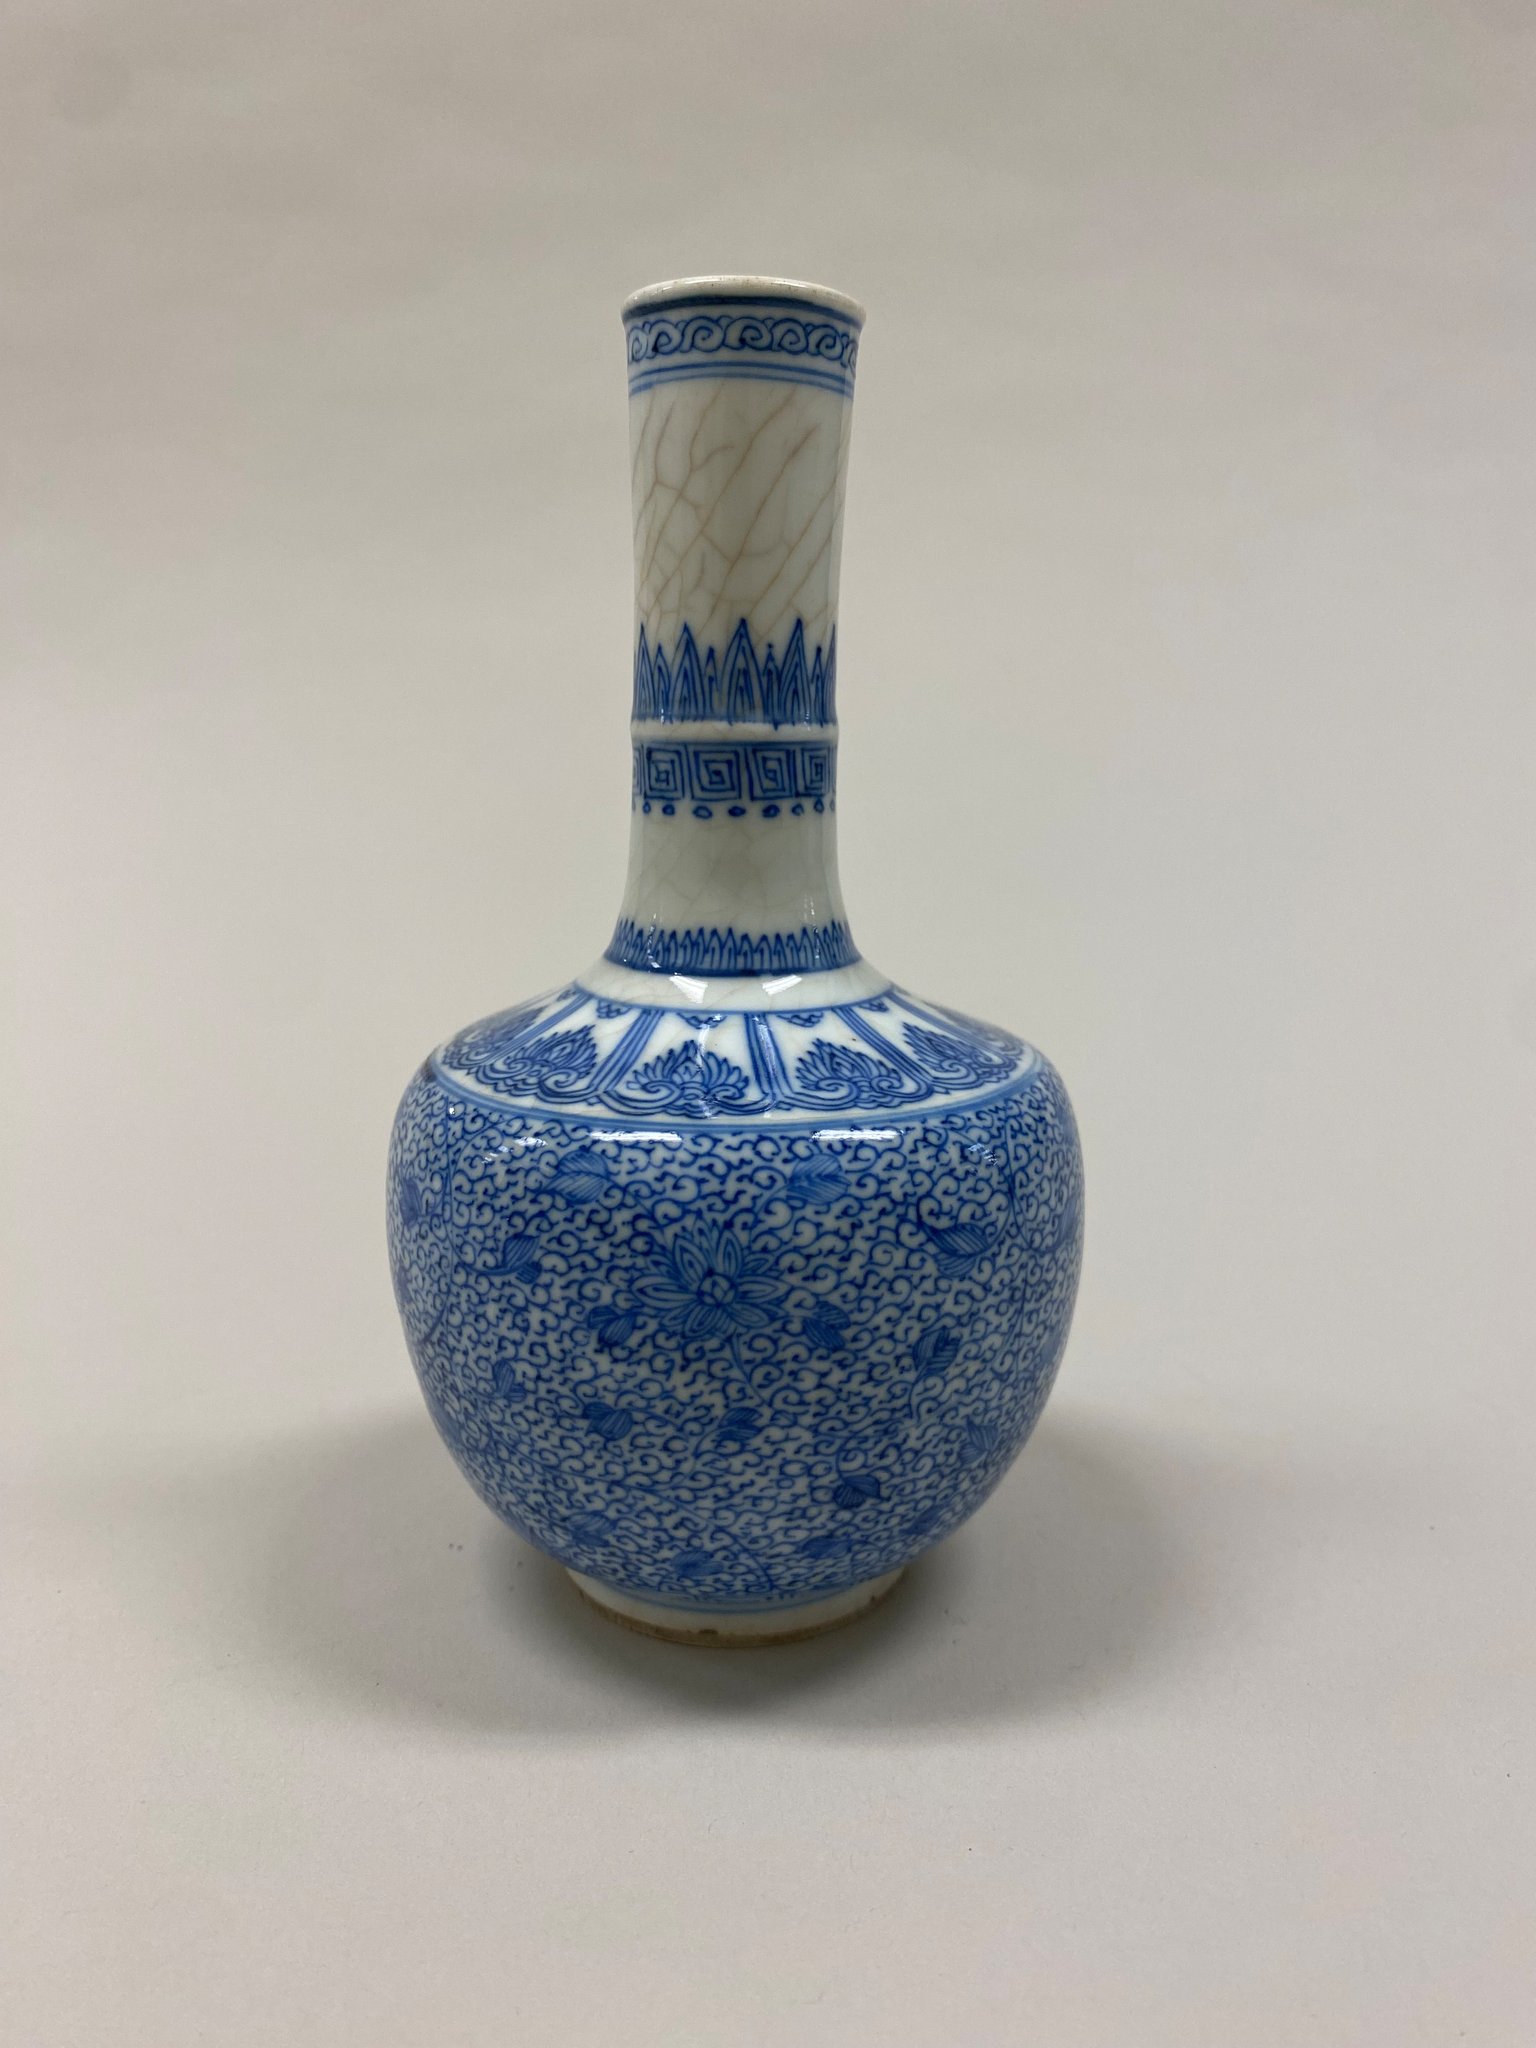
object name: bottle vase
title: Bottle vase with floral scrolls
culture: chinese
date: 1701-1733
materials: cobalt, soft paste porcelain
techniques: painting, underglaze